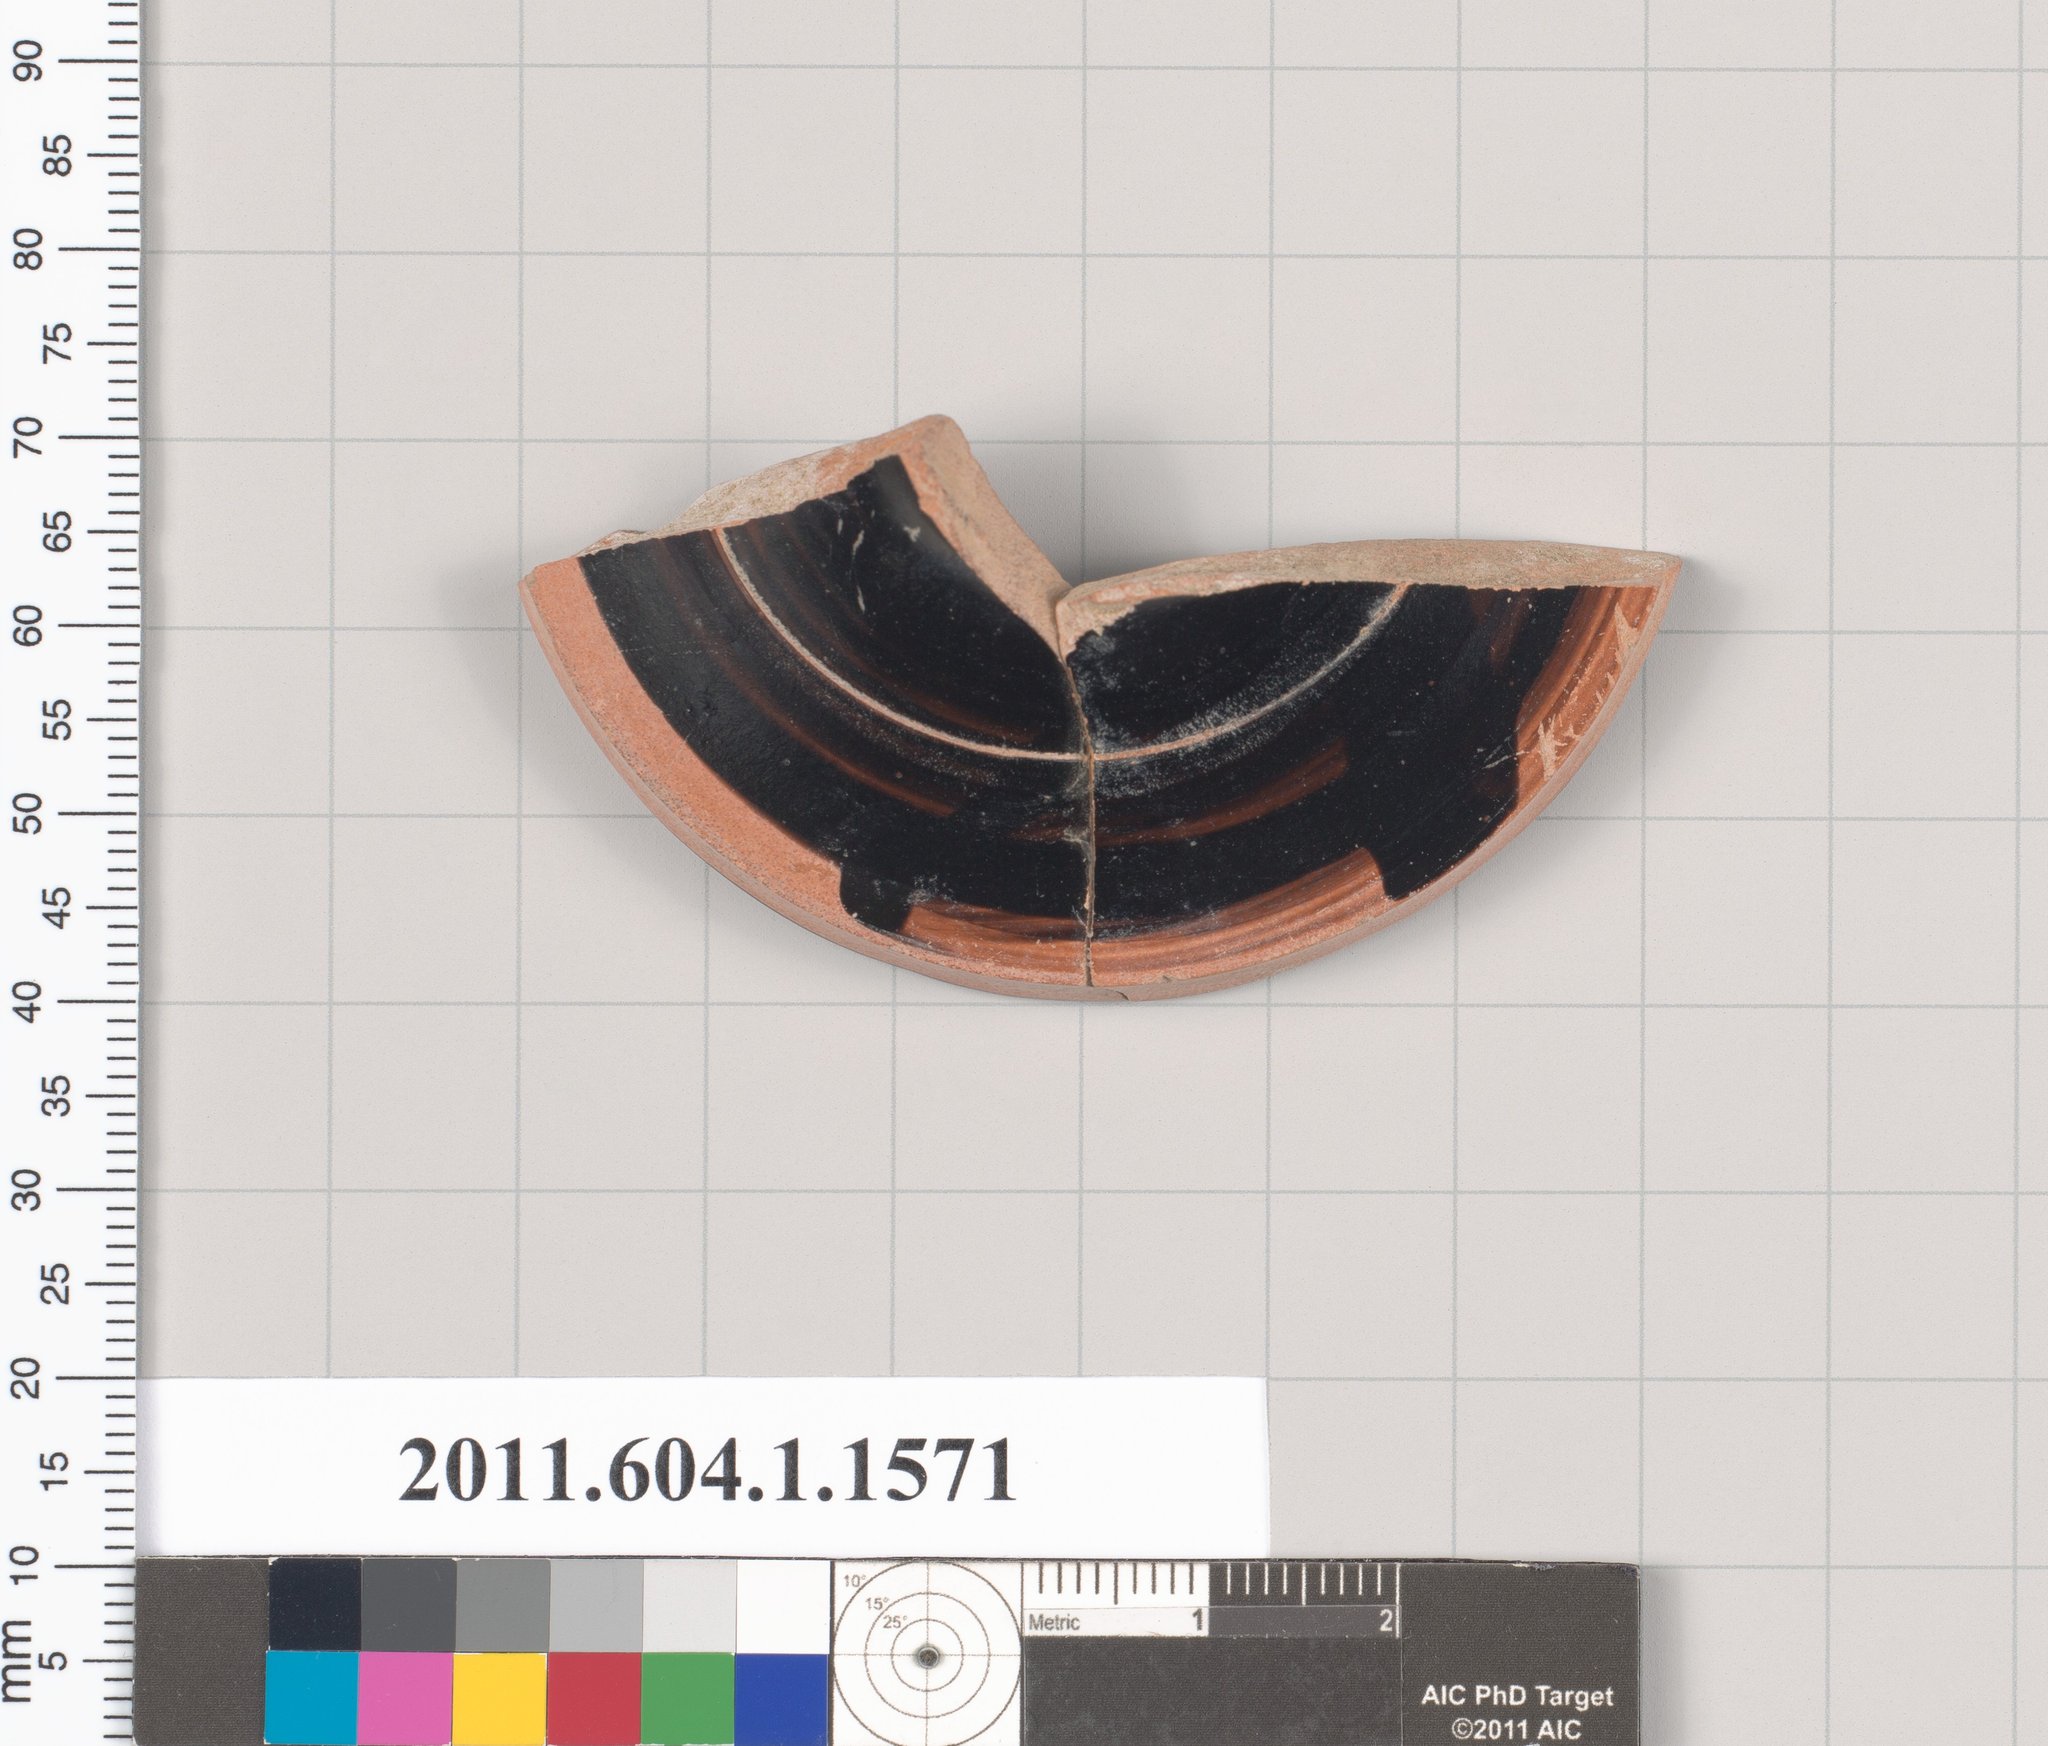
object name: kylix fragment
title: Terracotta fragment of a kylix (drinking cup)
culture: greek, attic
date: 500-401 BCE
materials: terracotta